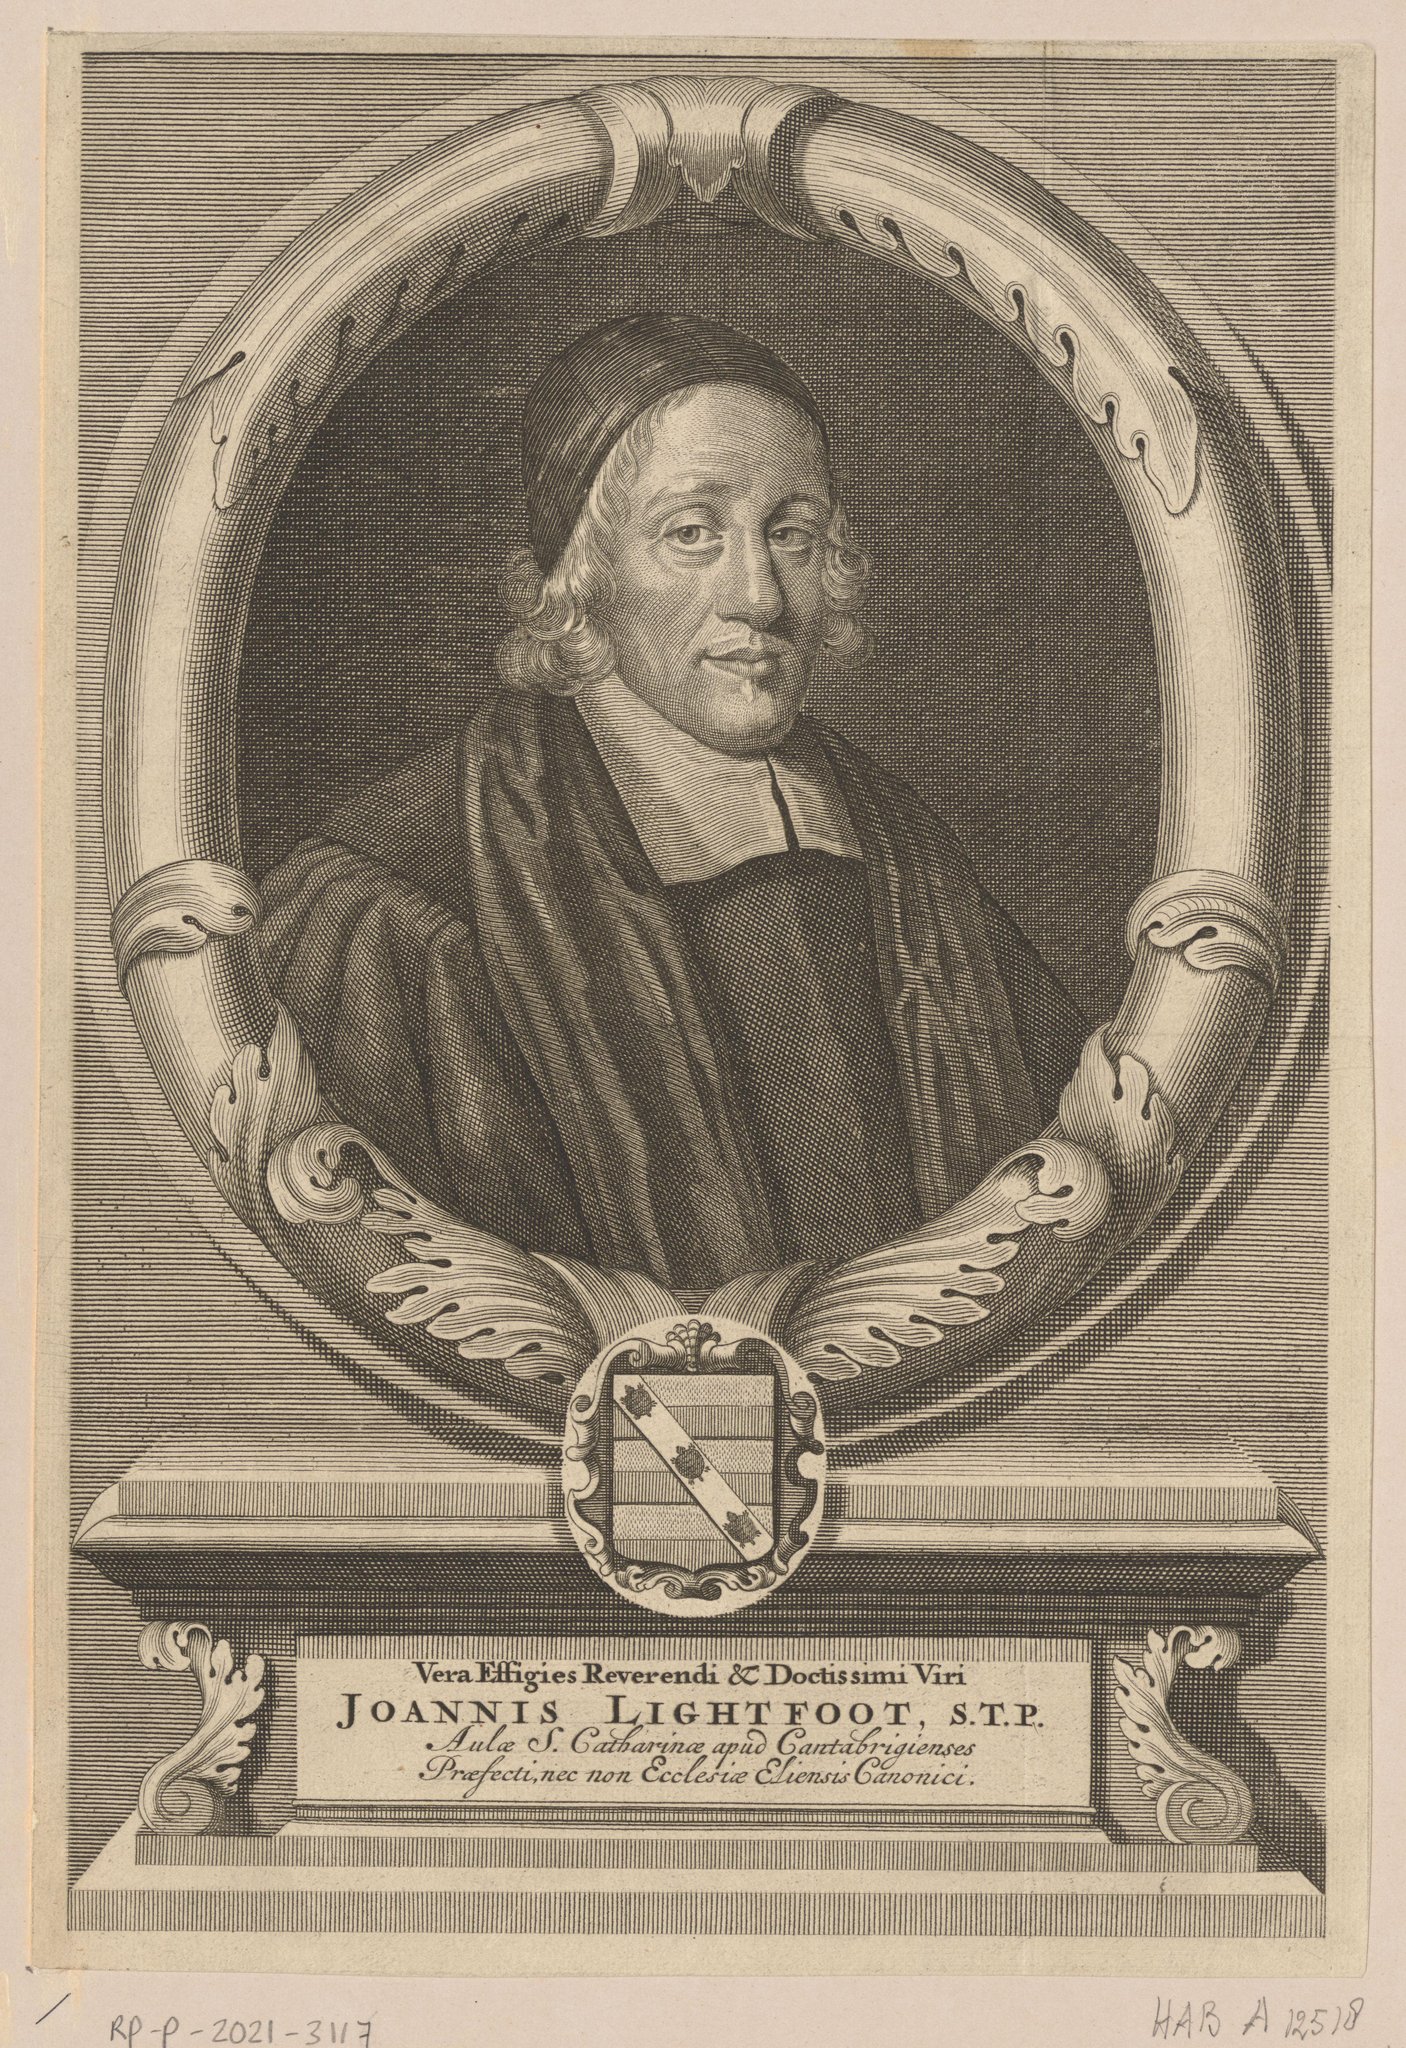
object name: print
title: Portret van John Lightfoot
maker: Anonymous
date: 1699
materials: paper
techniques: engraving, etching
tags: clergyman, ornament ~ medallion, historical persons, armorial bearing, heraldry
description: Prent waarschijnlijk uit: Lightfoot, John. Opera Omnia (...). Utrecht: Willem Broedelet, 1699, dl. 1. Of uit de editie van dit werk uitgegeven in Franeker in 1699.